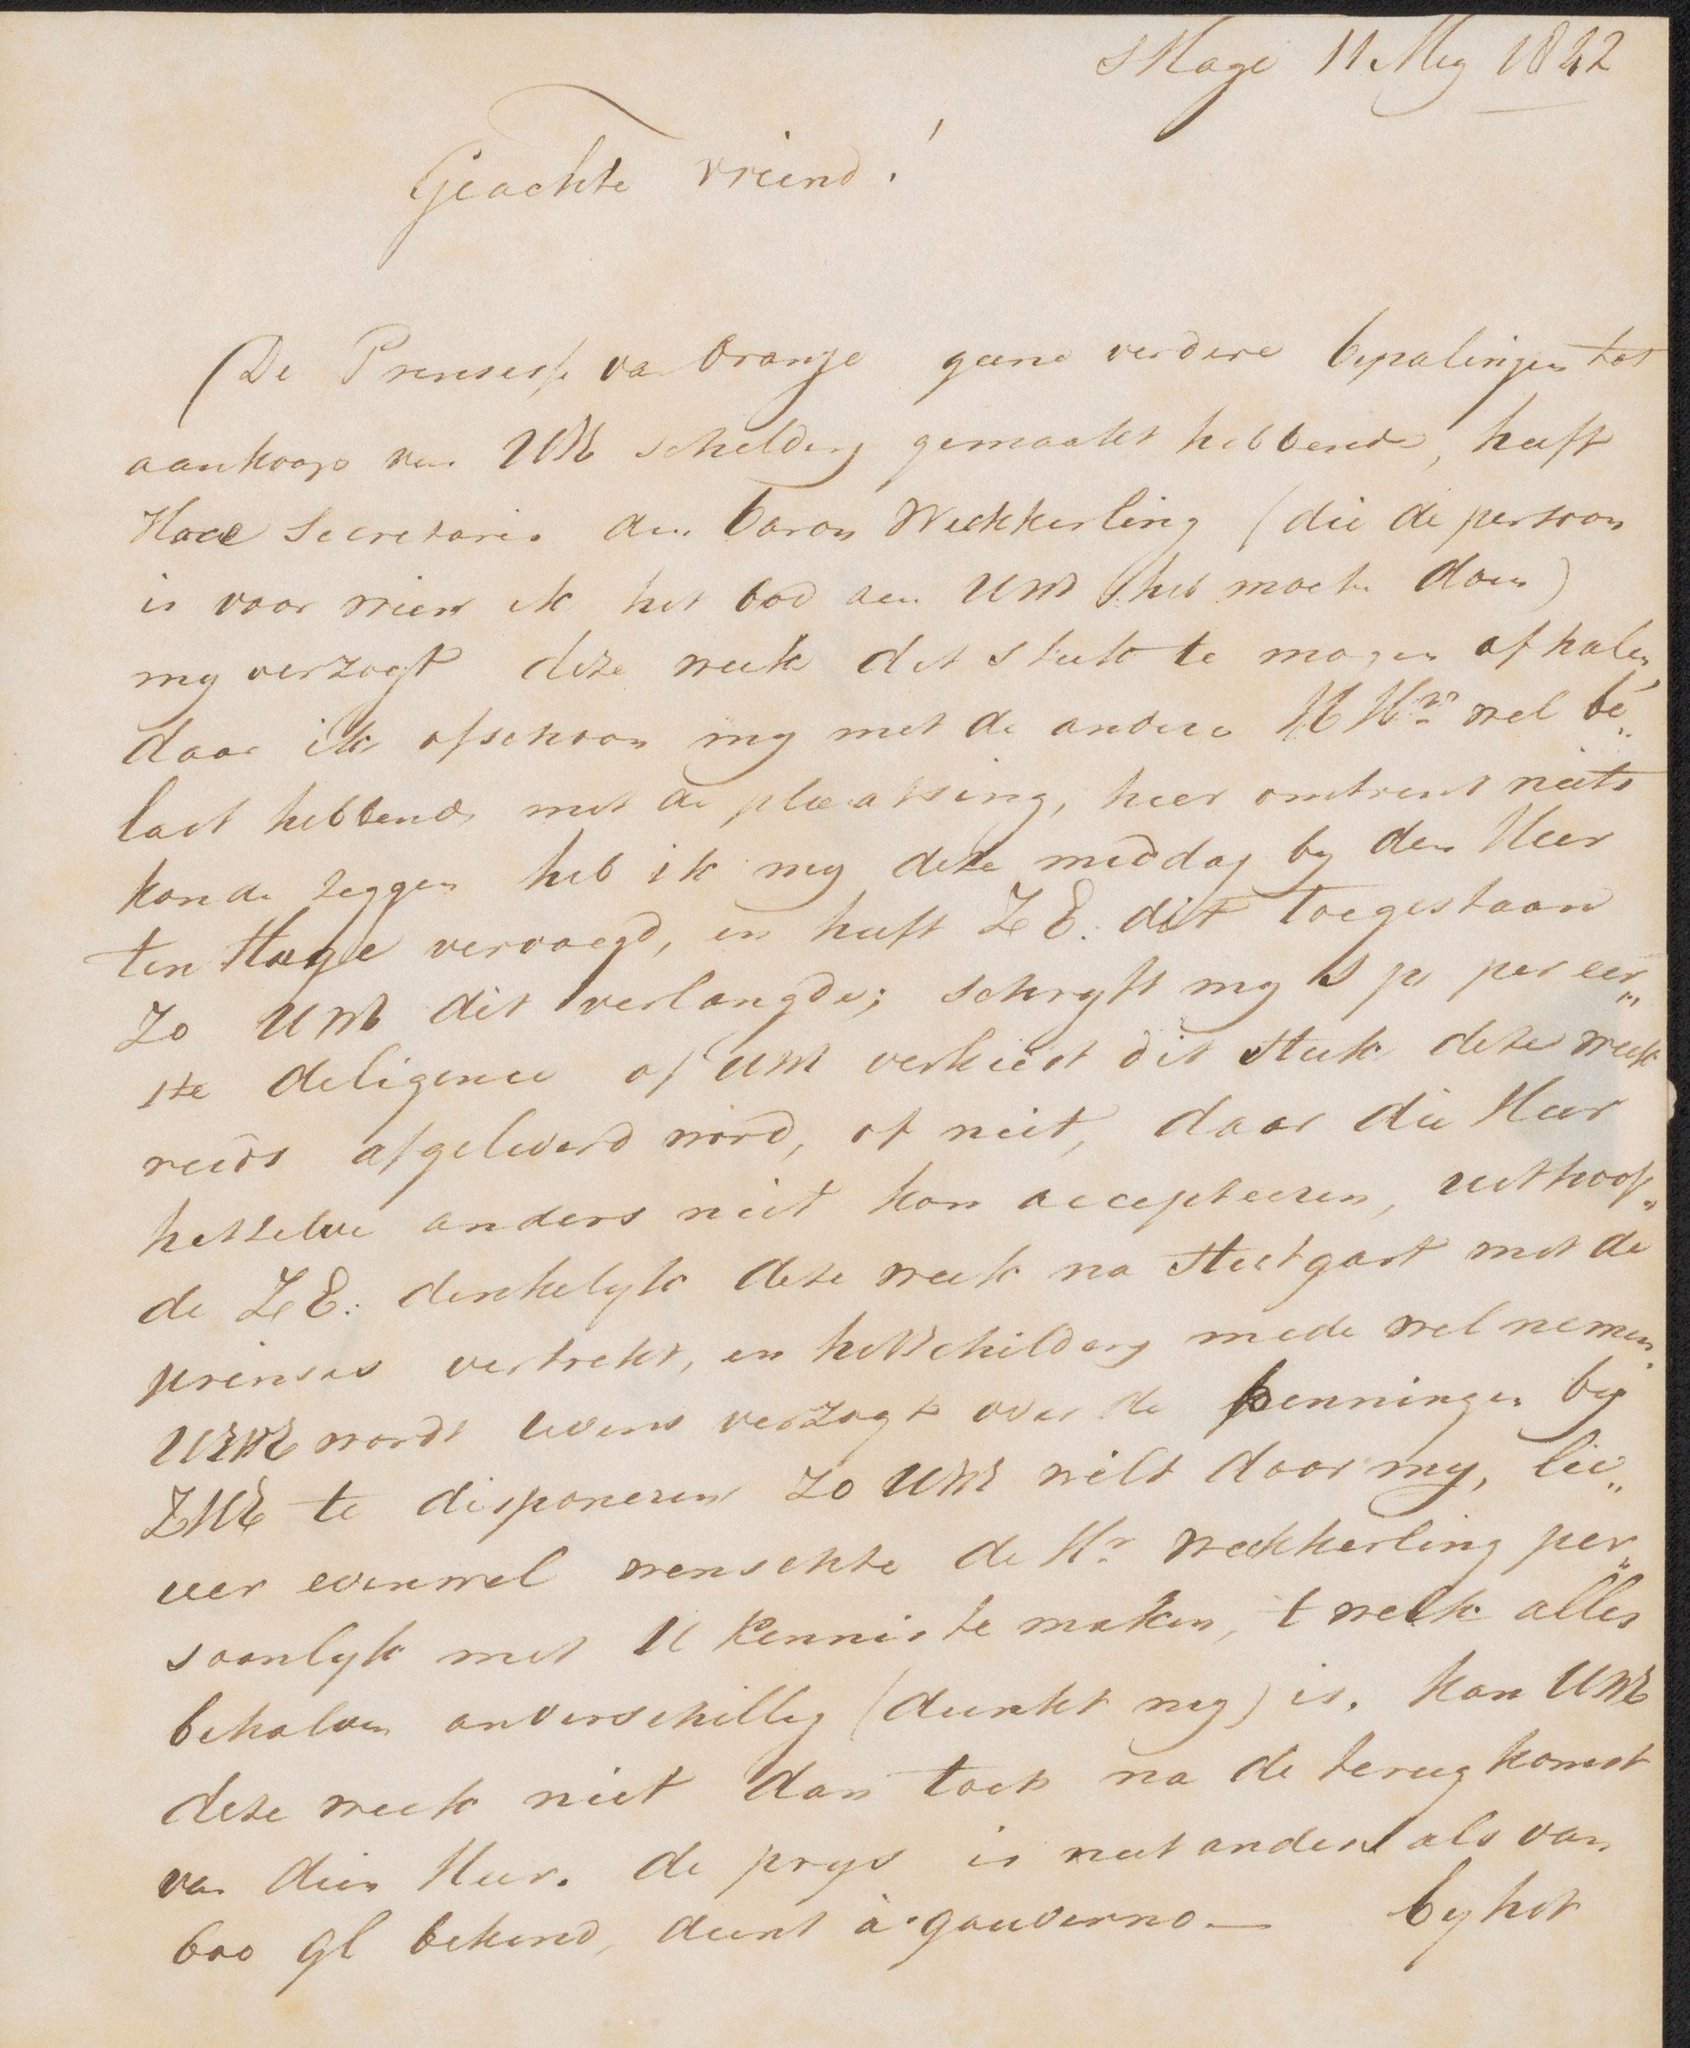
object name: letter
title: Brief aan Ary Johannes Lamme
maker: hendrikus van de sande bakhuyzen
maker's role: draughtsman, painter, print maker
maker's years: 1795-1860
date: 1842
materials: ink, paper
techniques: pen, writing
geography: the hague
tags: ary johannes lamme, sophia frederika mathilda van württemberg, art trade, art shop, painting (including book-illumination, miniature-painting), art collecting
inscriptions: collector's mark: Lugt 2228